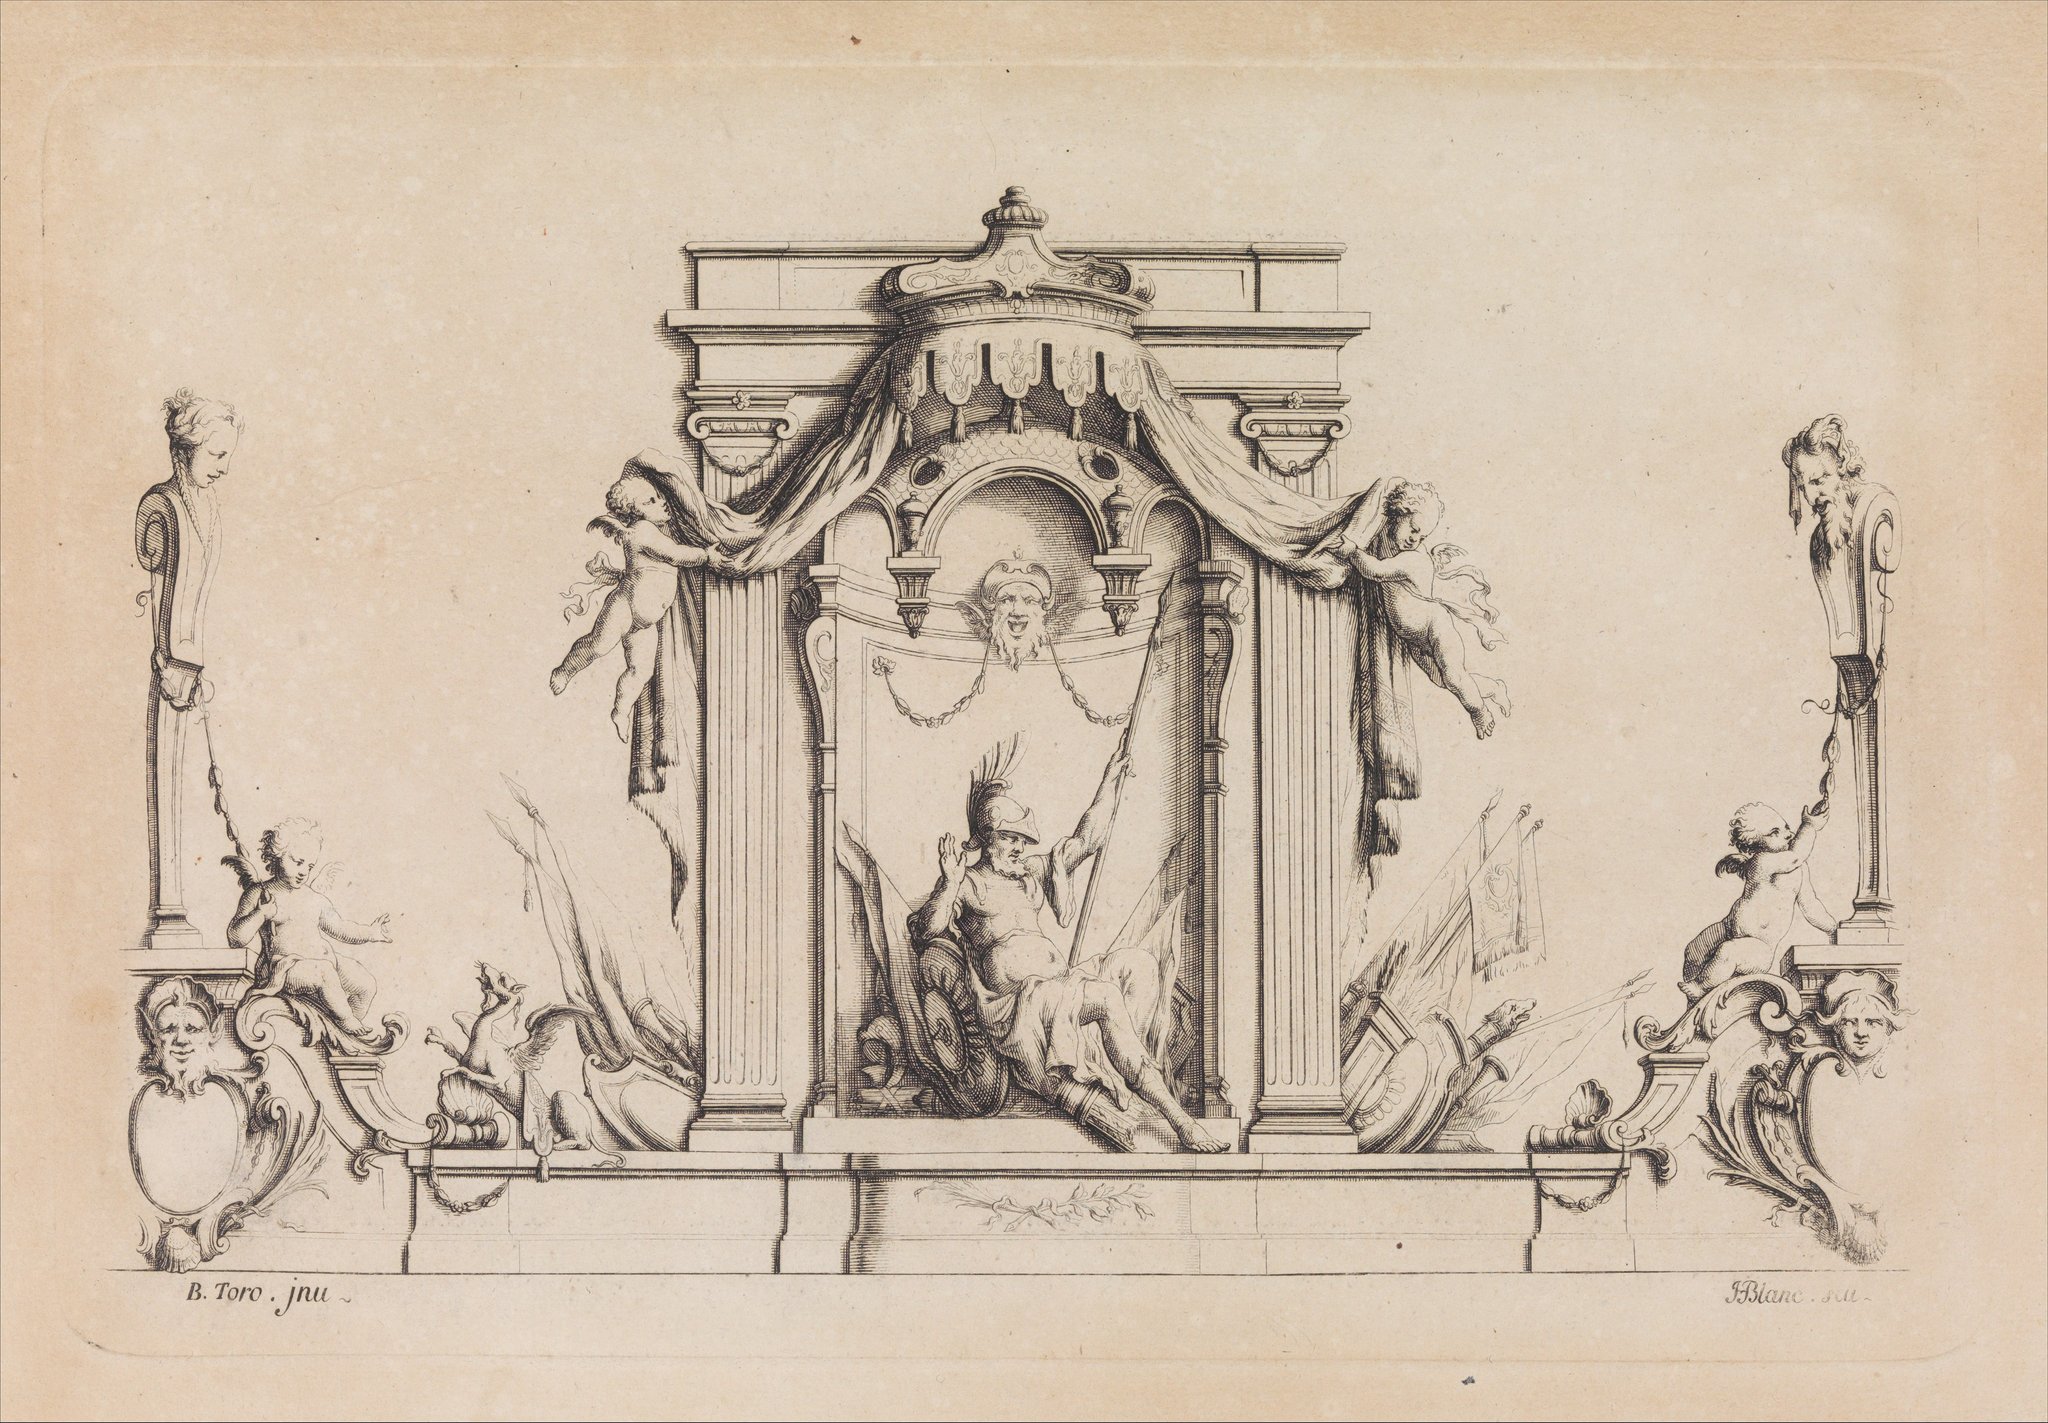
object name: album print ornament architecture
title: Desseins a Plusieurs Usages Inventés par M. B. Toro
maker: jean bernard toro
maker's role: designer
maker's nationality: french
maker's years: 1672-1731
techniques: etching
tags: shields,spears,men